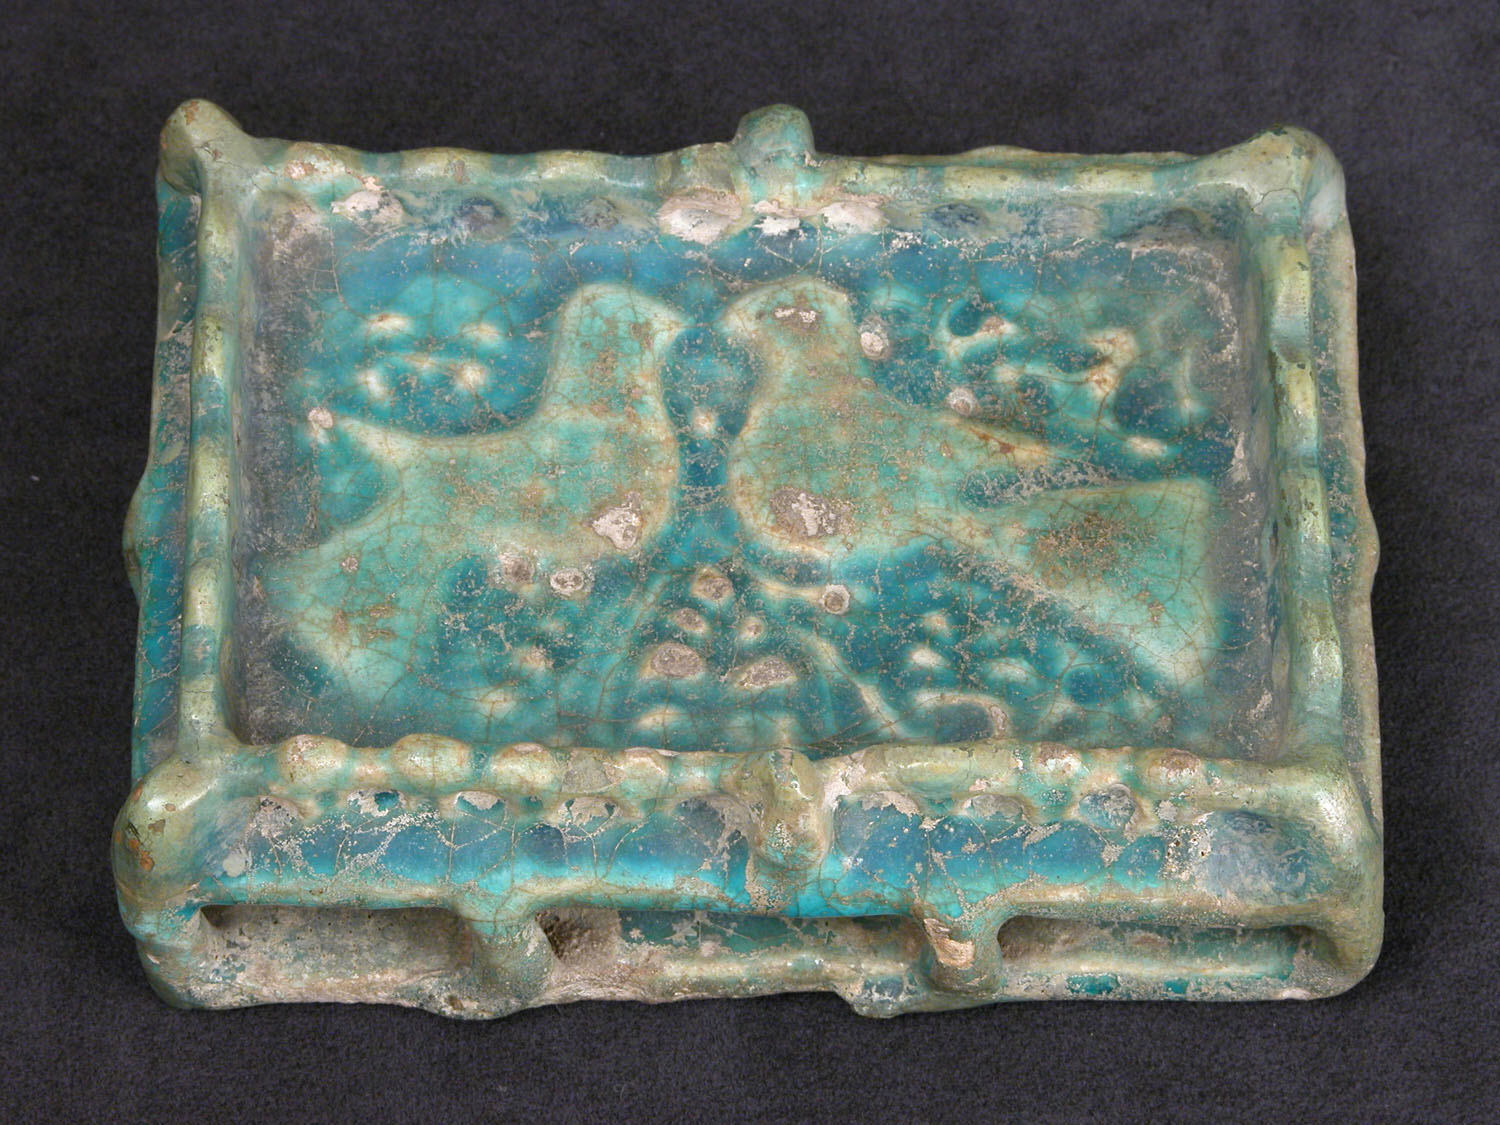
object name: model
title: Model of a House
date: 1101-1233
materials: stonepaste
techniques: molding, relief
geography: iran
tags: birds